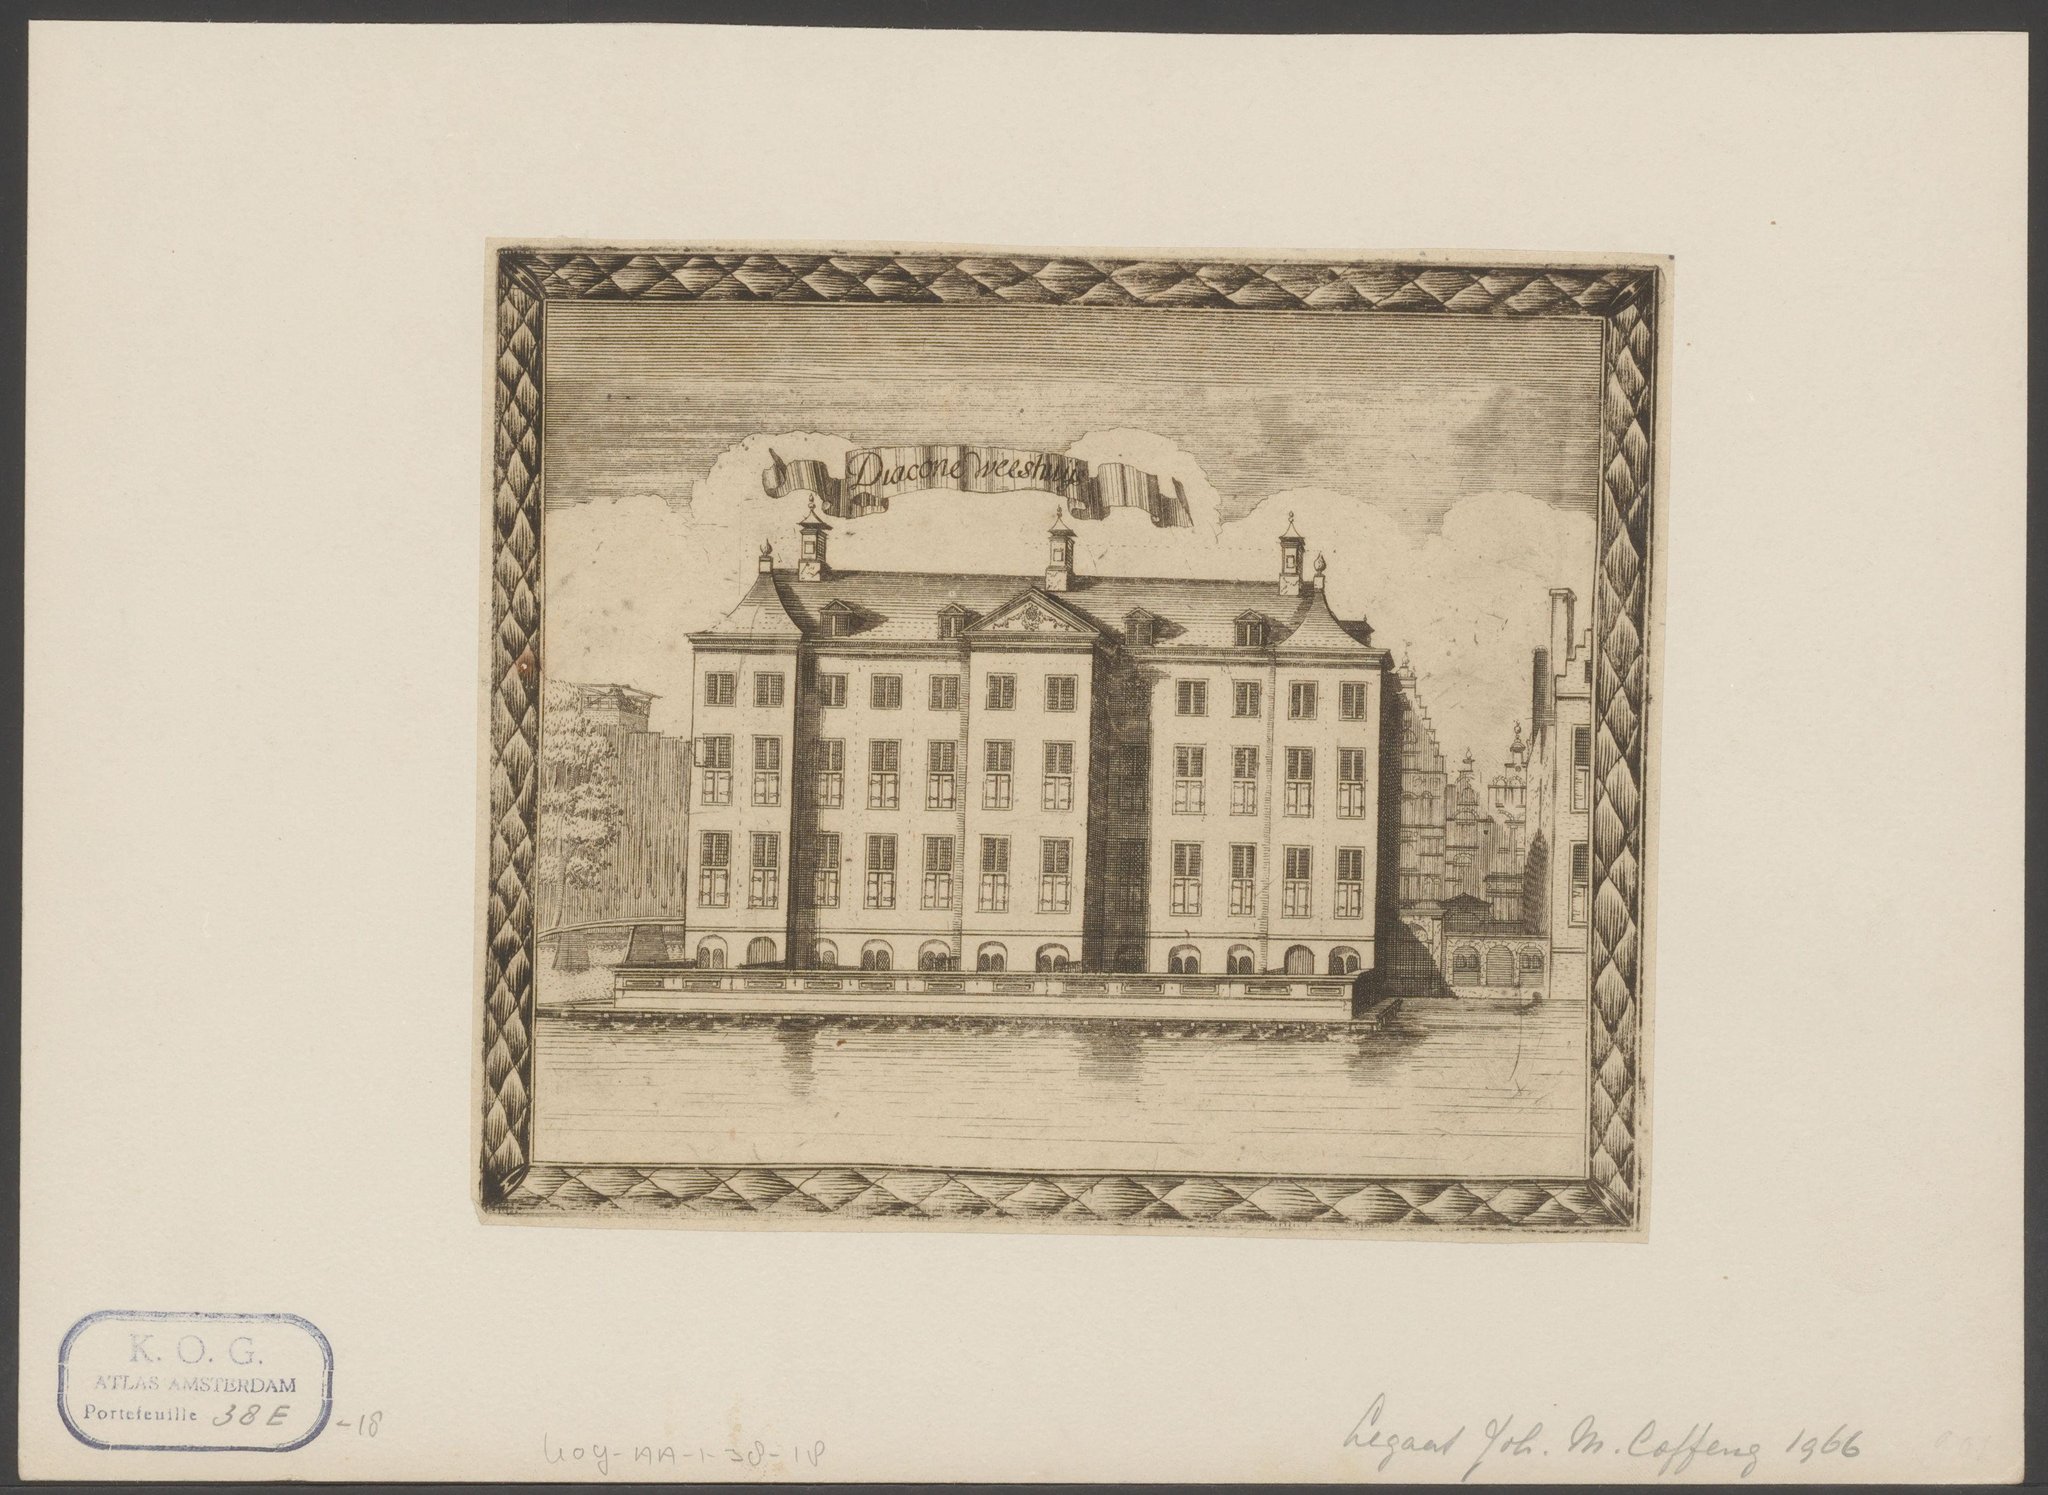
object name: print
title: Gezicht op het Diaconieweeshuis te Amsterdam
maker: romeyn de hooghe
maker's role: draughtsman, goldsmith, painter, print maker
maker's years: 1645-1708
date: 1670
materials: paper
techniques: engraving, etching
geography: amsterdam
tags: orphanage, canals, waters (in city) (+ city(-scape) with figures, staffage)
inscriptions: collector's mark: Lugt 1641b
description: Prent maakt deel uit van een compositie gedrukt van meerdere platen, met naast een gezicht op het Diaconieweeshuis te Amsterdam ook een gezicht op Amsterdam (zie KOG-AA-1-1-46B), een gezicht op de haven van Amsterdam (zie KOG-AA-1-1-46A), een gezicht op het Aalmoezeniersweeshuis te Amsterdam en een gezicht op het Prinsenhof te Amsterdam.